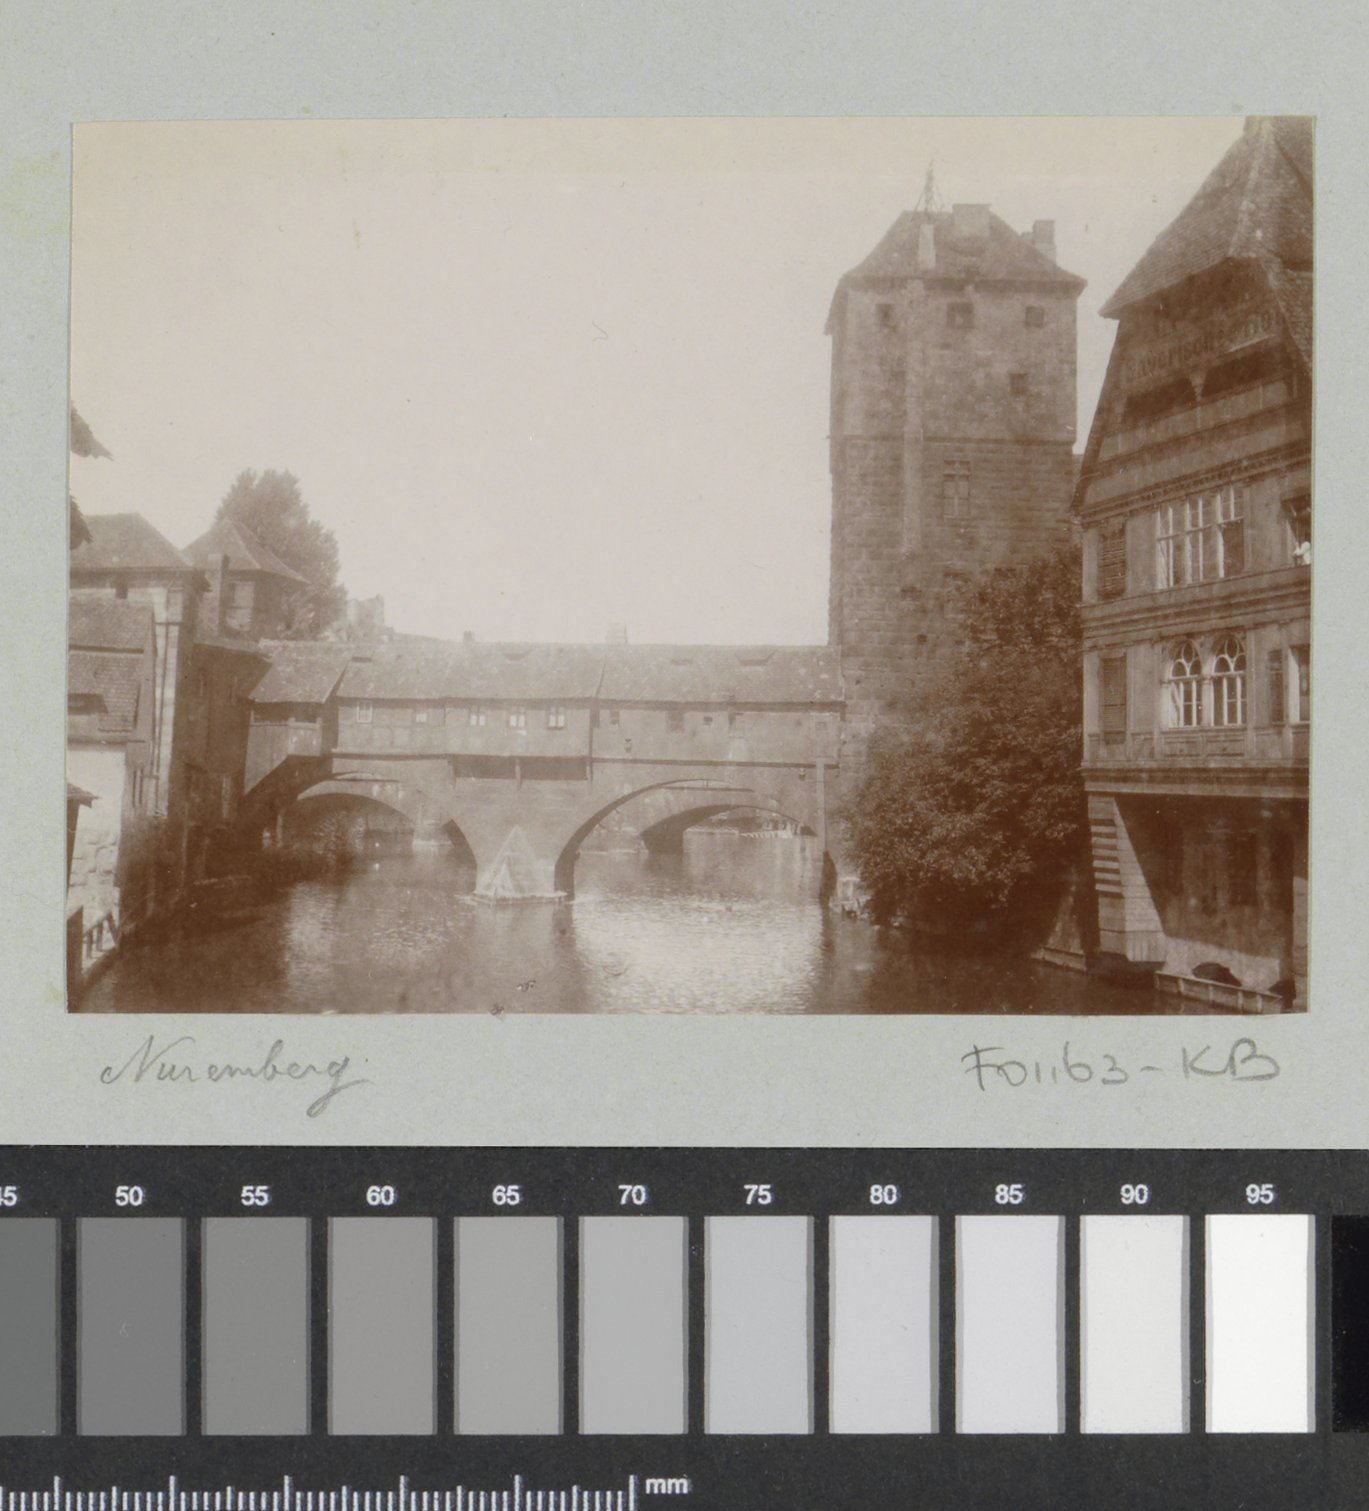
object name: photograph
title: Gezicht op de Henkerstegbrug tussen de watertoren (rechts) en de Henkertoren (links) in Neurenberg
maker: delizy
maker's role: manufacturer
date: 1900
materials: paper, photographic support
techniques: gelatin silver print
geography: nuremberg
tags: water tower, bridge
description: Onderdeel van Fotoalbum van een Franse amateurfotograaf met opnames van uitstapjes in Frankrijk, Spanje, België, Luxemburg en Nederland, de eerste automobielen en autoraces.